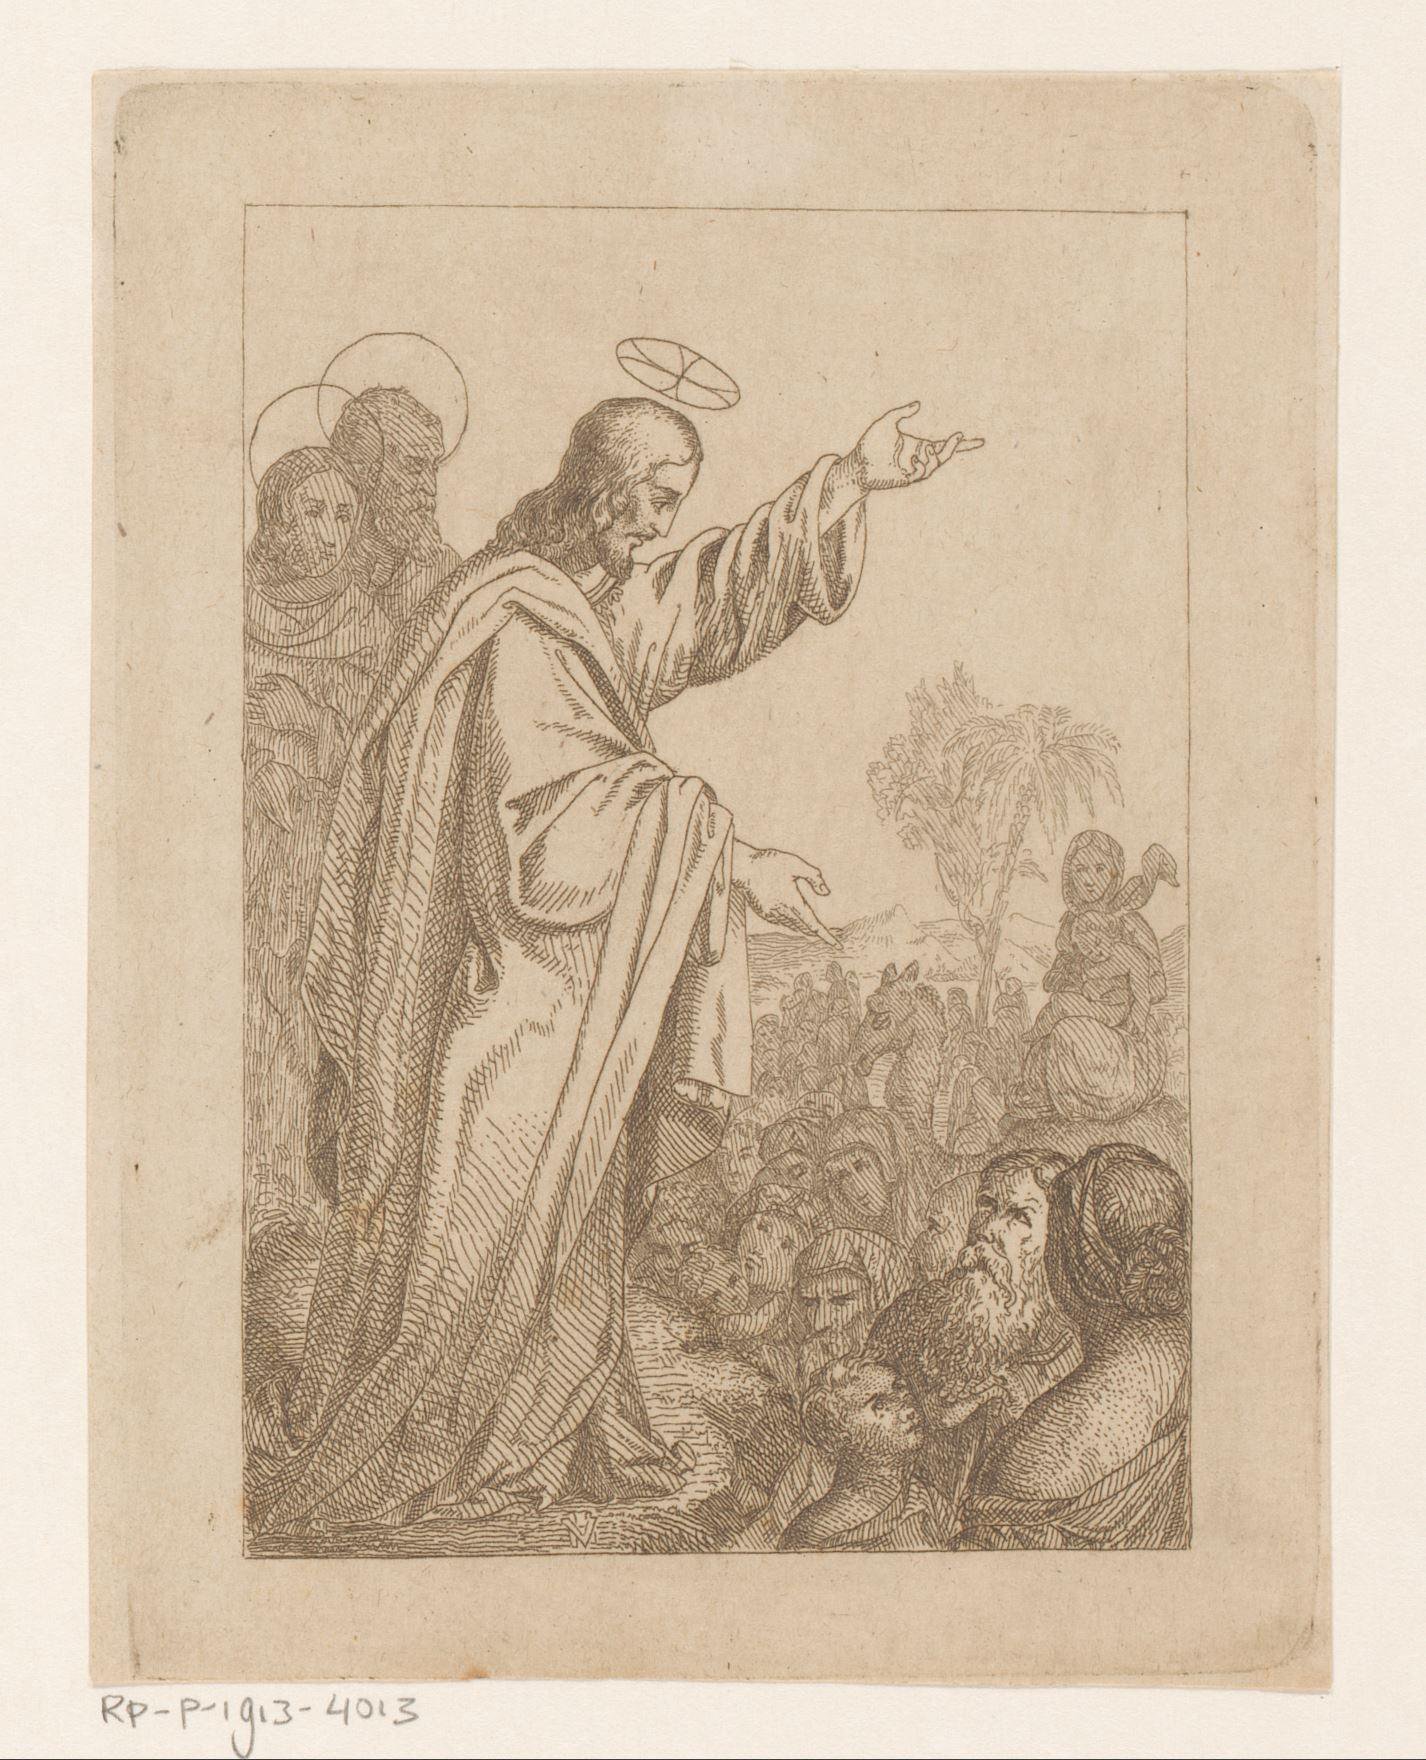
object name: print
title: Bergrede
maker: heinrich vianden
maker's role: painter, print maker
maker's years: 1814-1899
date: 1824-1899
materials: paper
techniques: etching, intaglio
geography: germany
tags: christ's sermon on the mount (matthew 5-7)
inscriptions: collector's mark: Lugt 2228, collector's mark: Lugt 1485